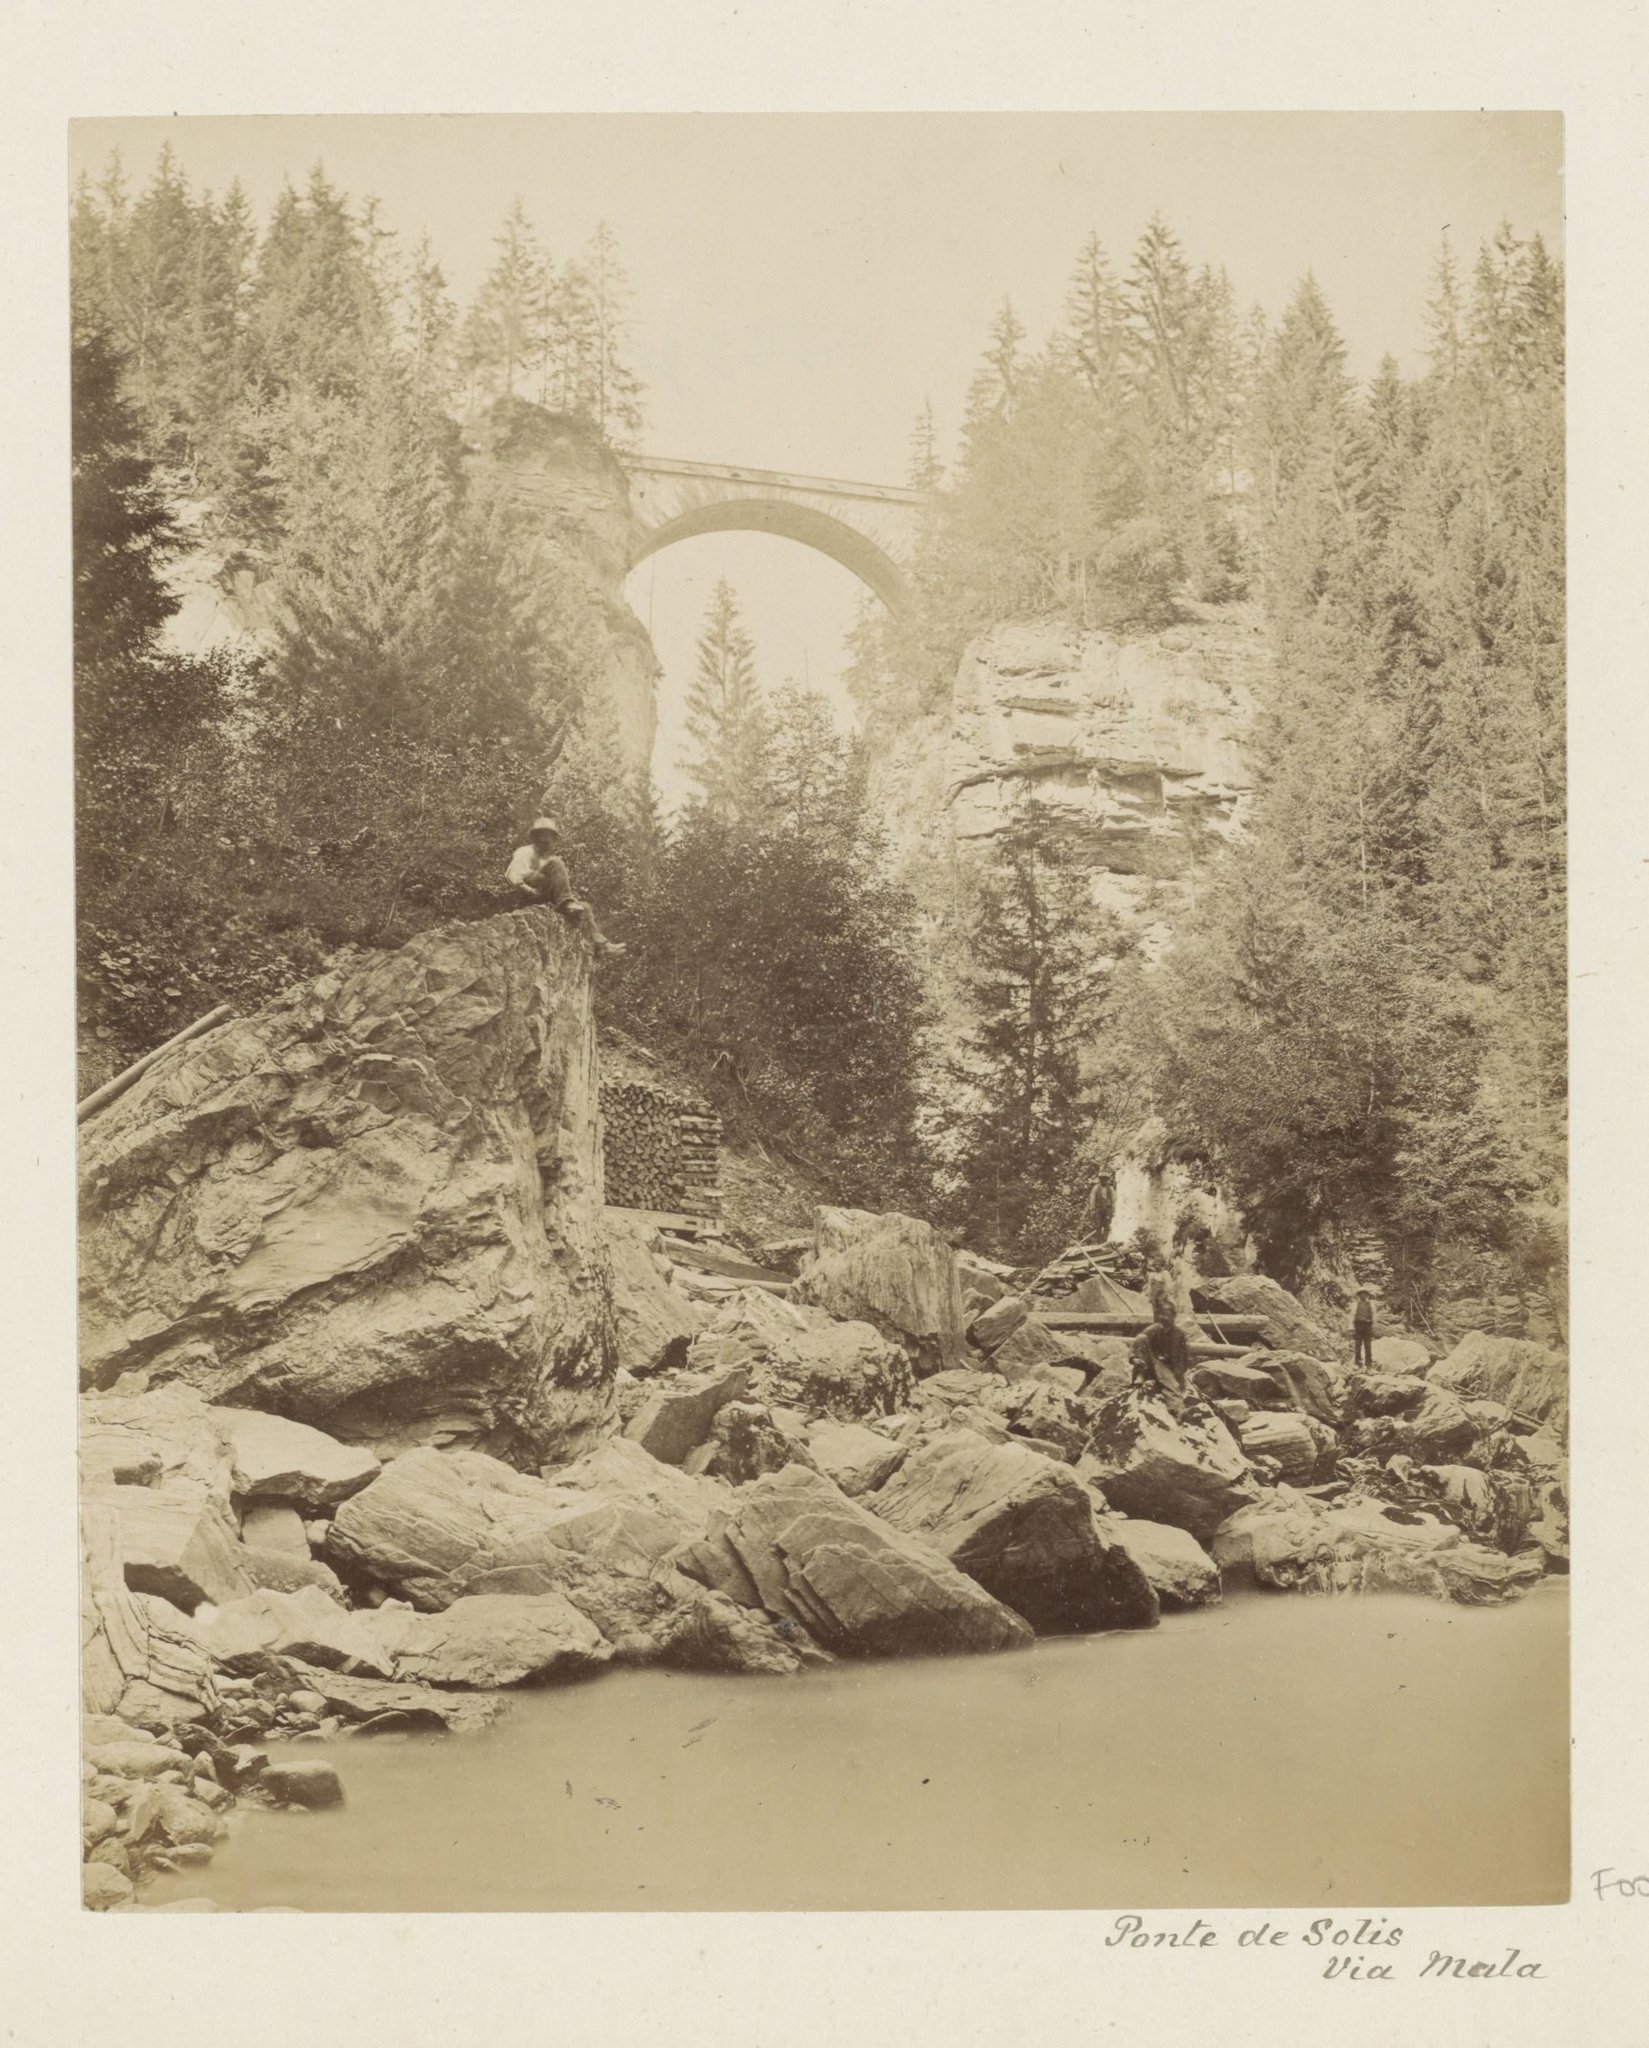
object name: photograph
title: Ponte de Solis Via Mala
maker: Anonymous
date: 1860-1890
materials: paper, photographic support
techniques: albumen print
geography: graubunden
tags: landscape with bridge, viaduct or aqueduct, outing, pleasure trip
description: Onderdeel van Reisalbum met foto's van Zwitserland, Oostenrijk, Italië en Duitsland.